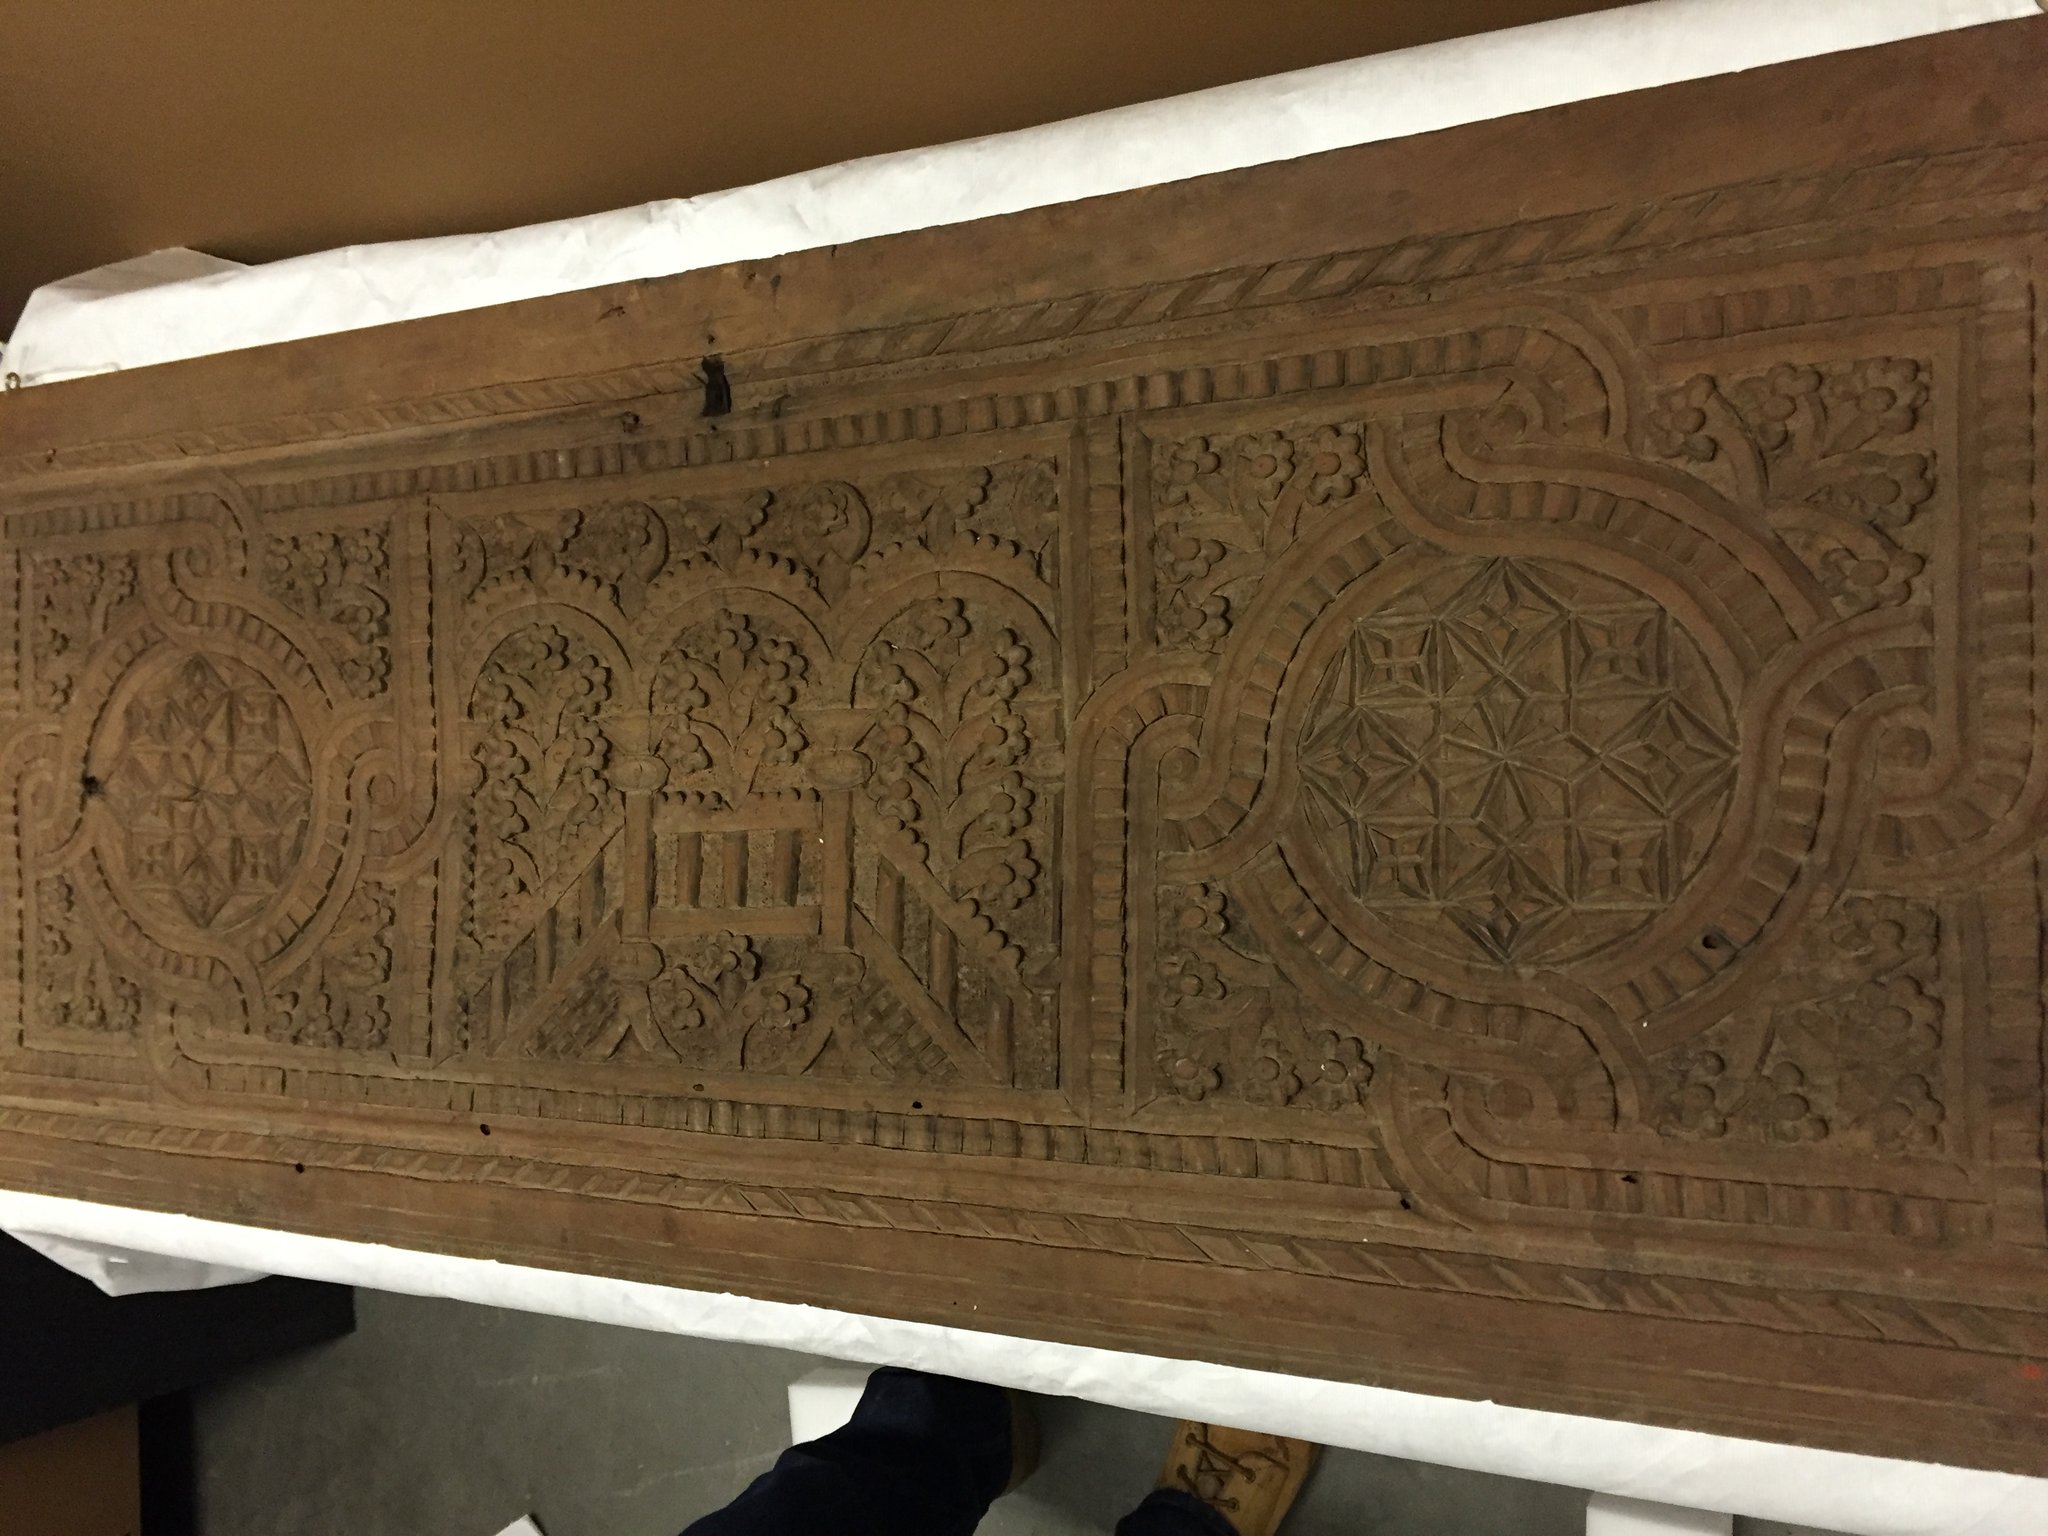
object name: chest front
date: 1701-1800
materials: wood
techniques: carving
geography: syria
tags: chests